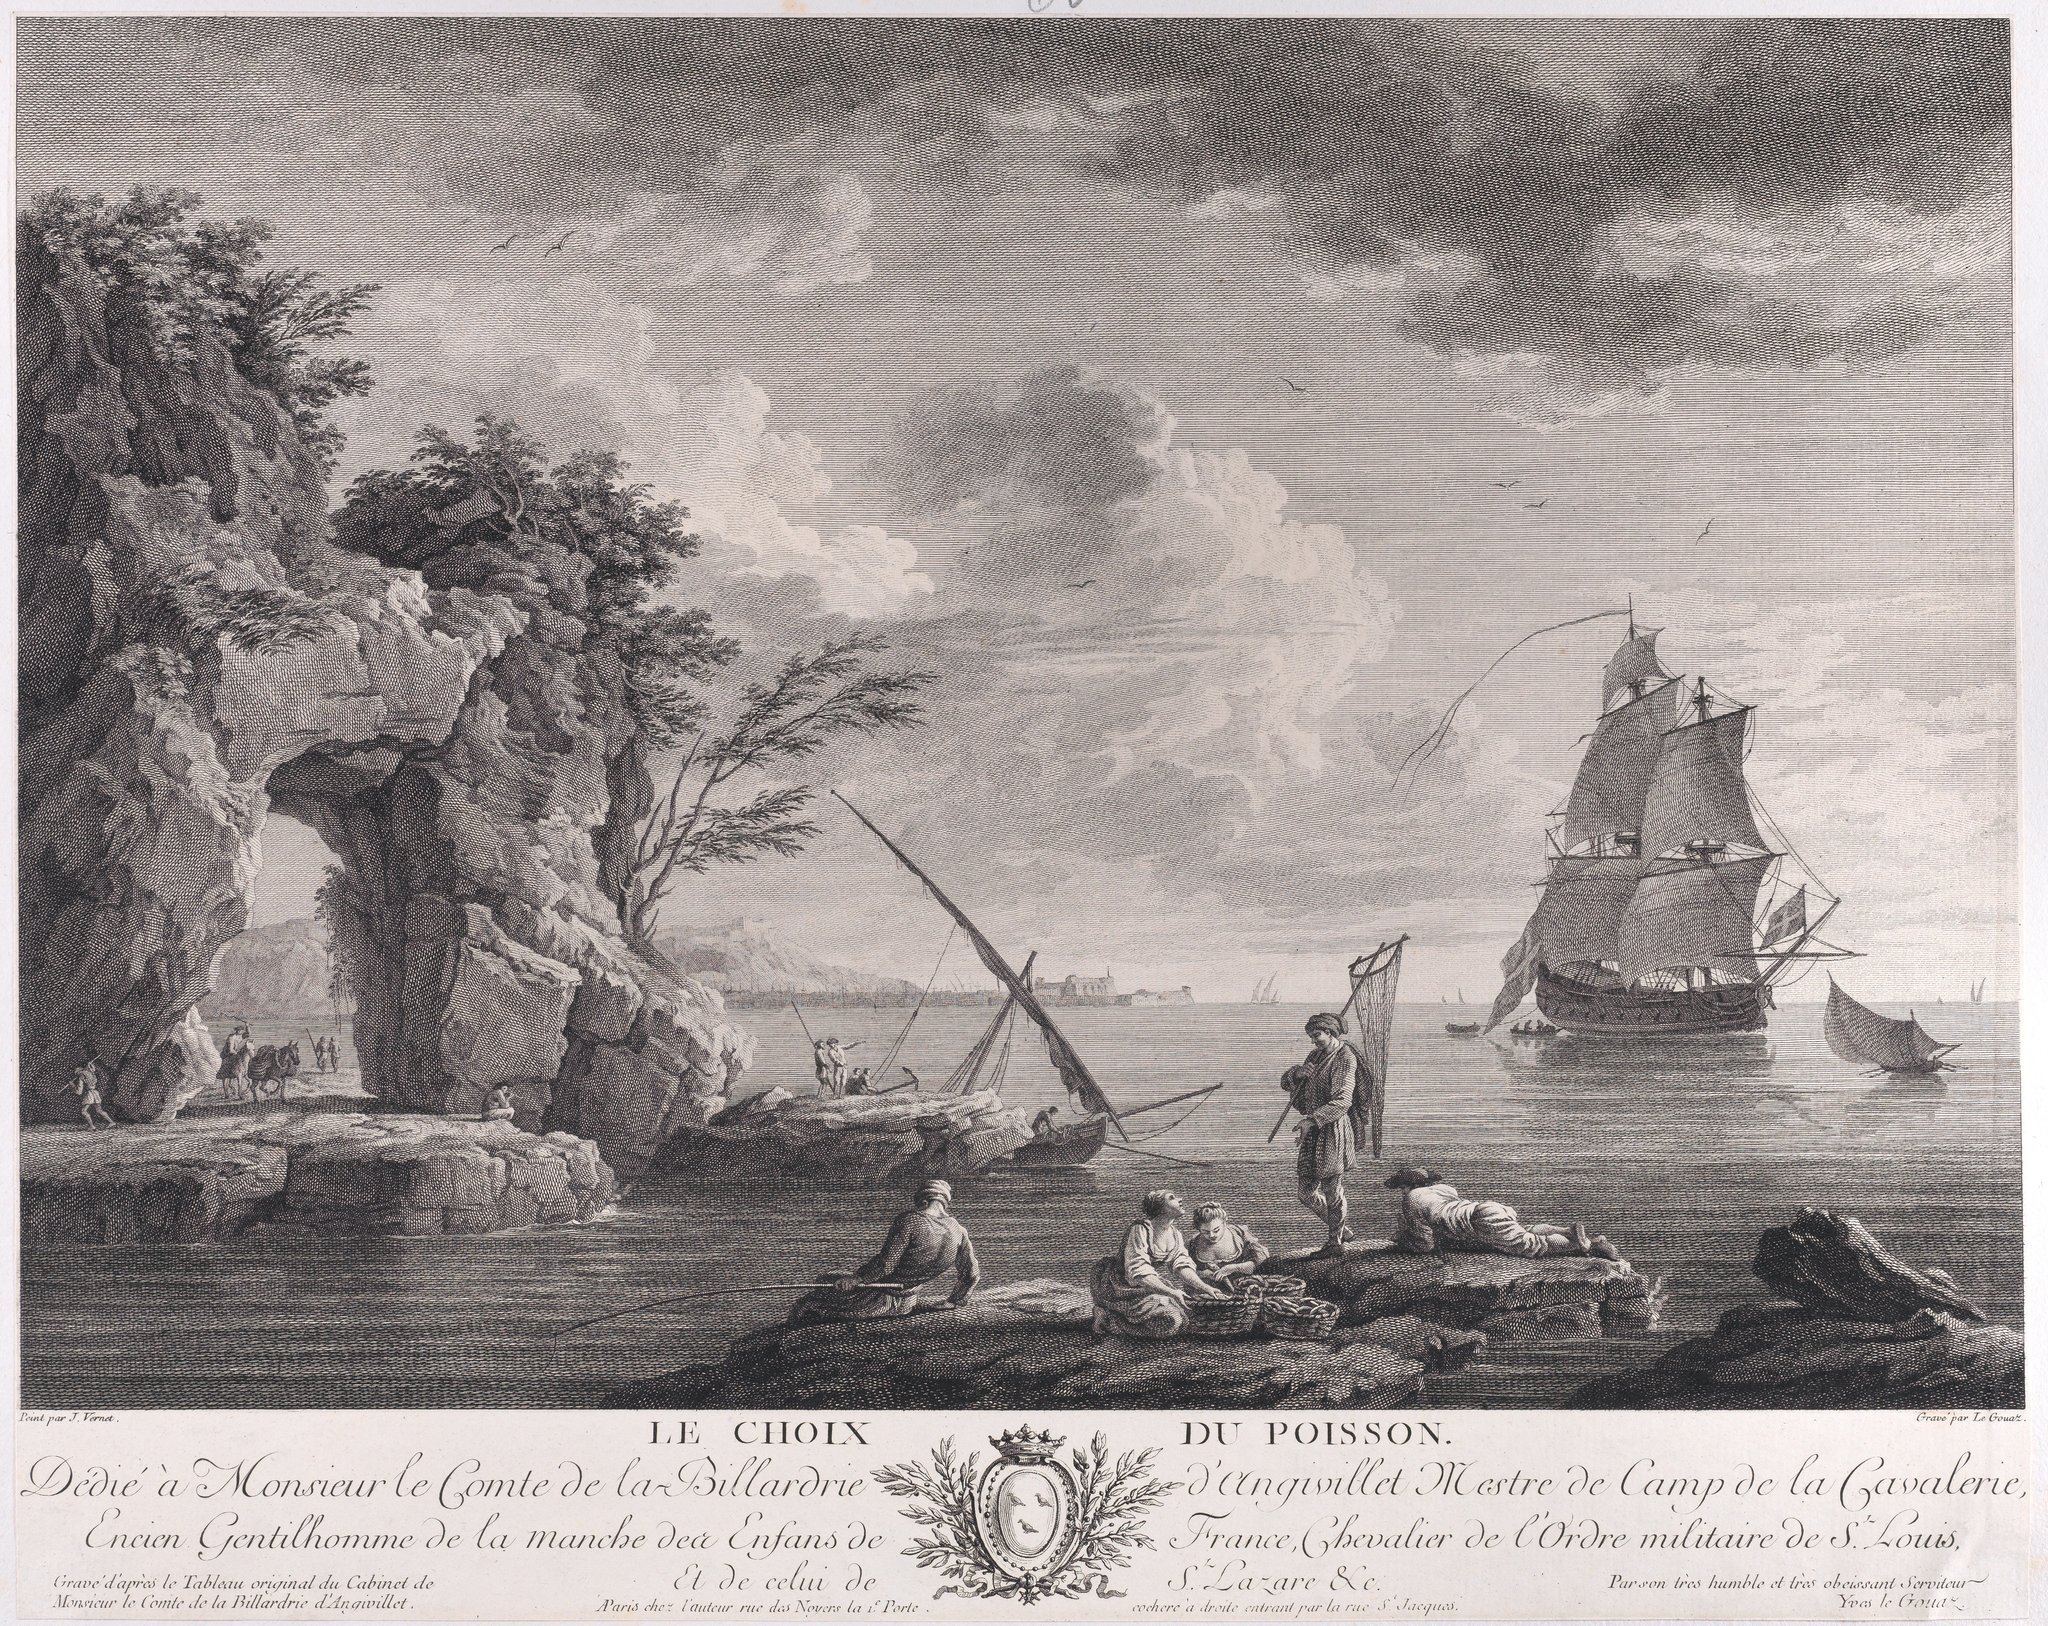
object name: print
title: The Choice of Fish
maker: joseph vernet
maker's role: artist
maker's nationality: french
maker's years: 1714-1789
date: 1770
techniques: engraving